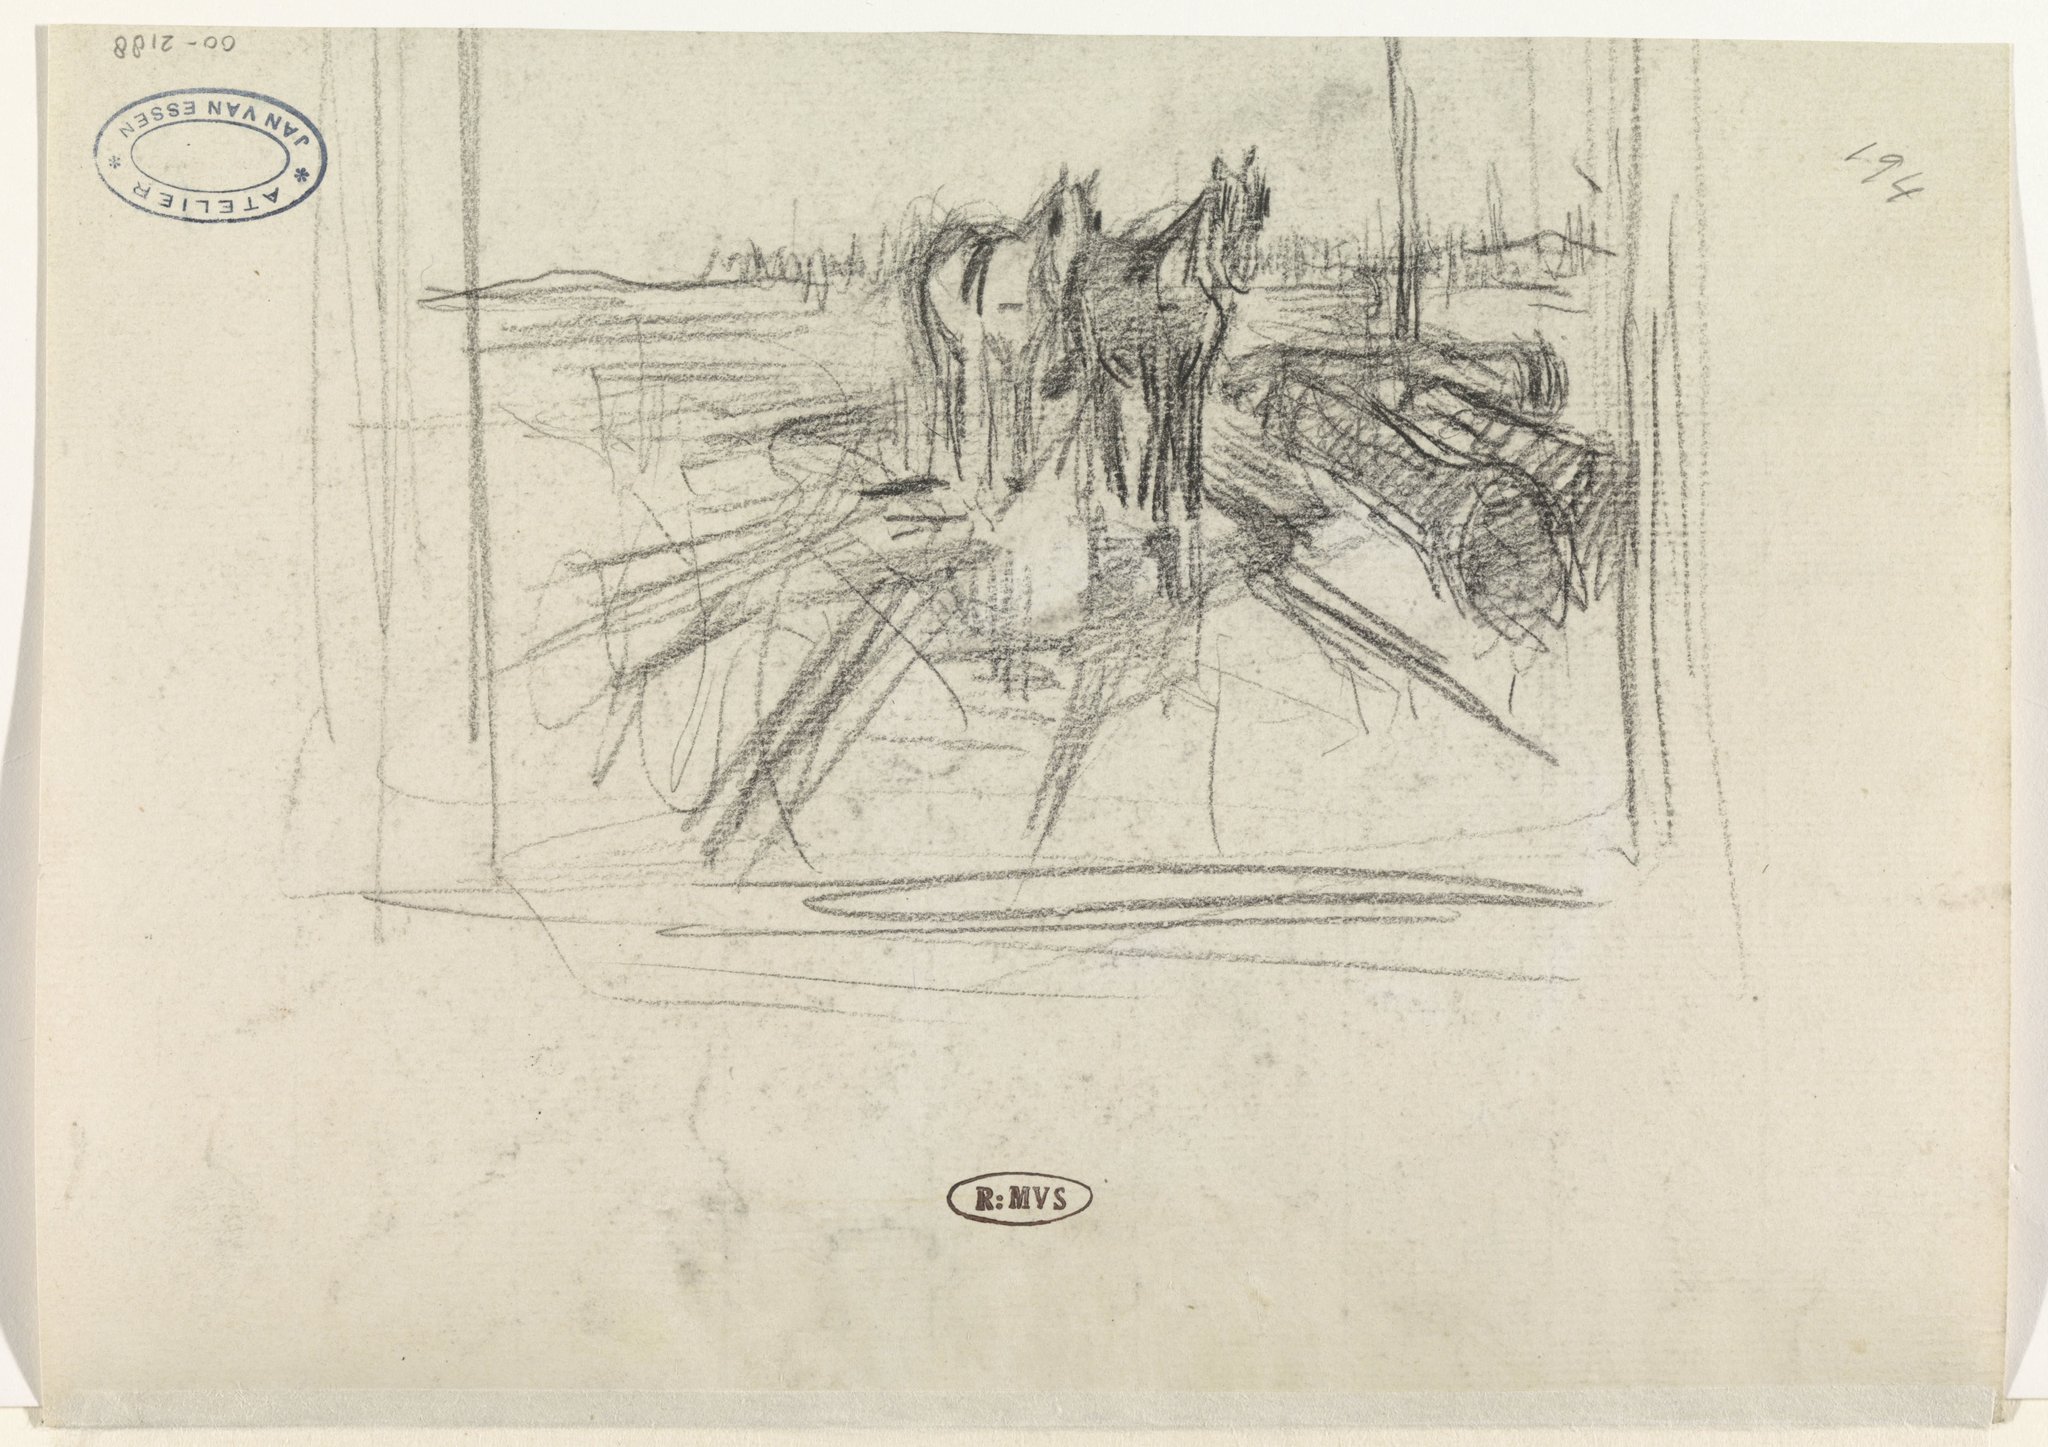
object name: drawing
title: Schets met enkele paarden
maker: jan van essen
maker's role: draughtsman, print maker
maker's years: 1854-1936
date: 1864-1936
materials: chalk, paper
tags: horse